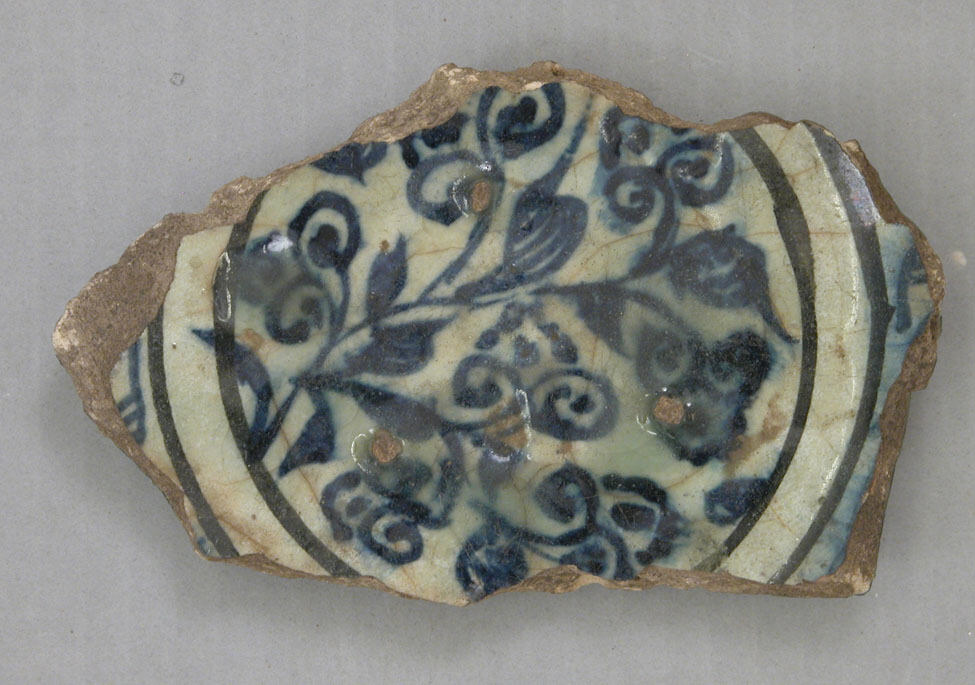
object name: fragment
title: Ceramic Fragment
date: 1401-1500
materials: glaze, stonepaste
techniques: painting, polychrome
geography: egypt or syria